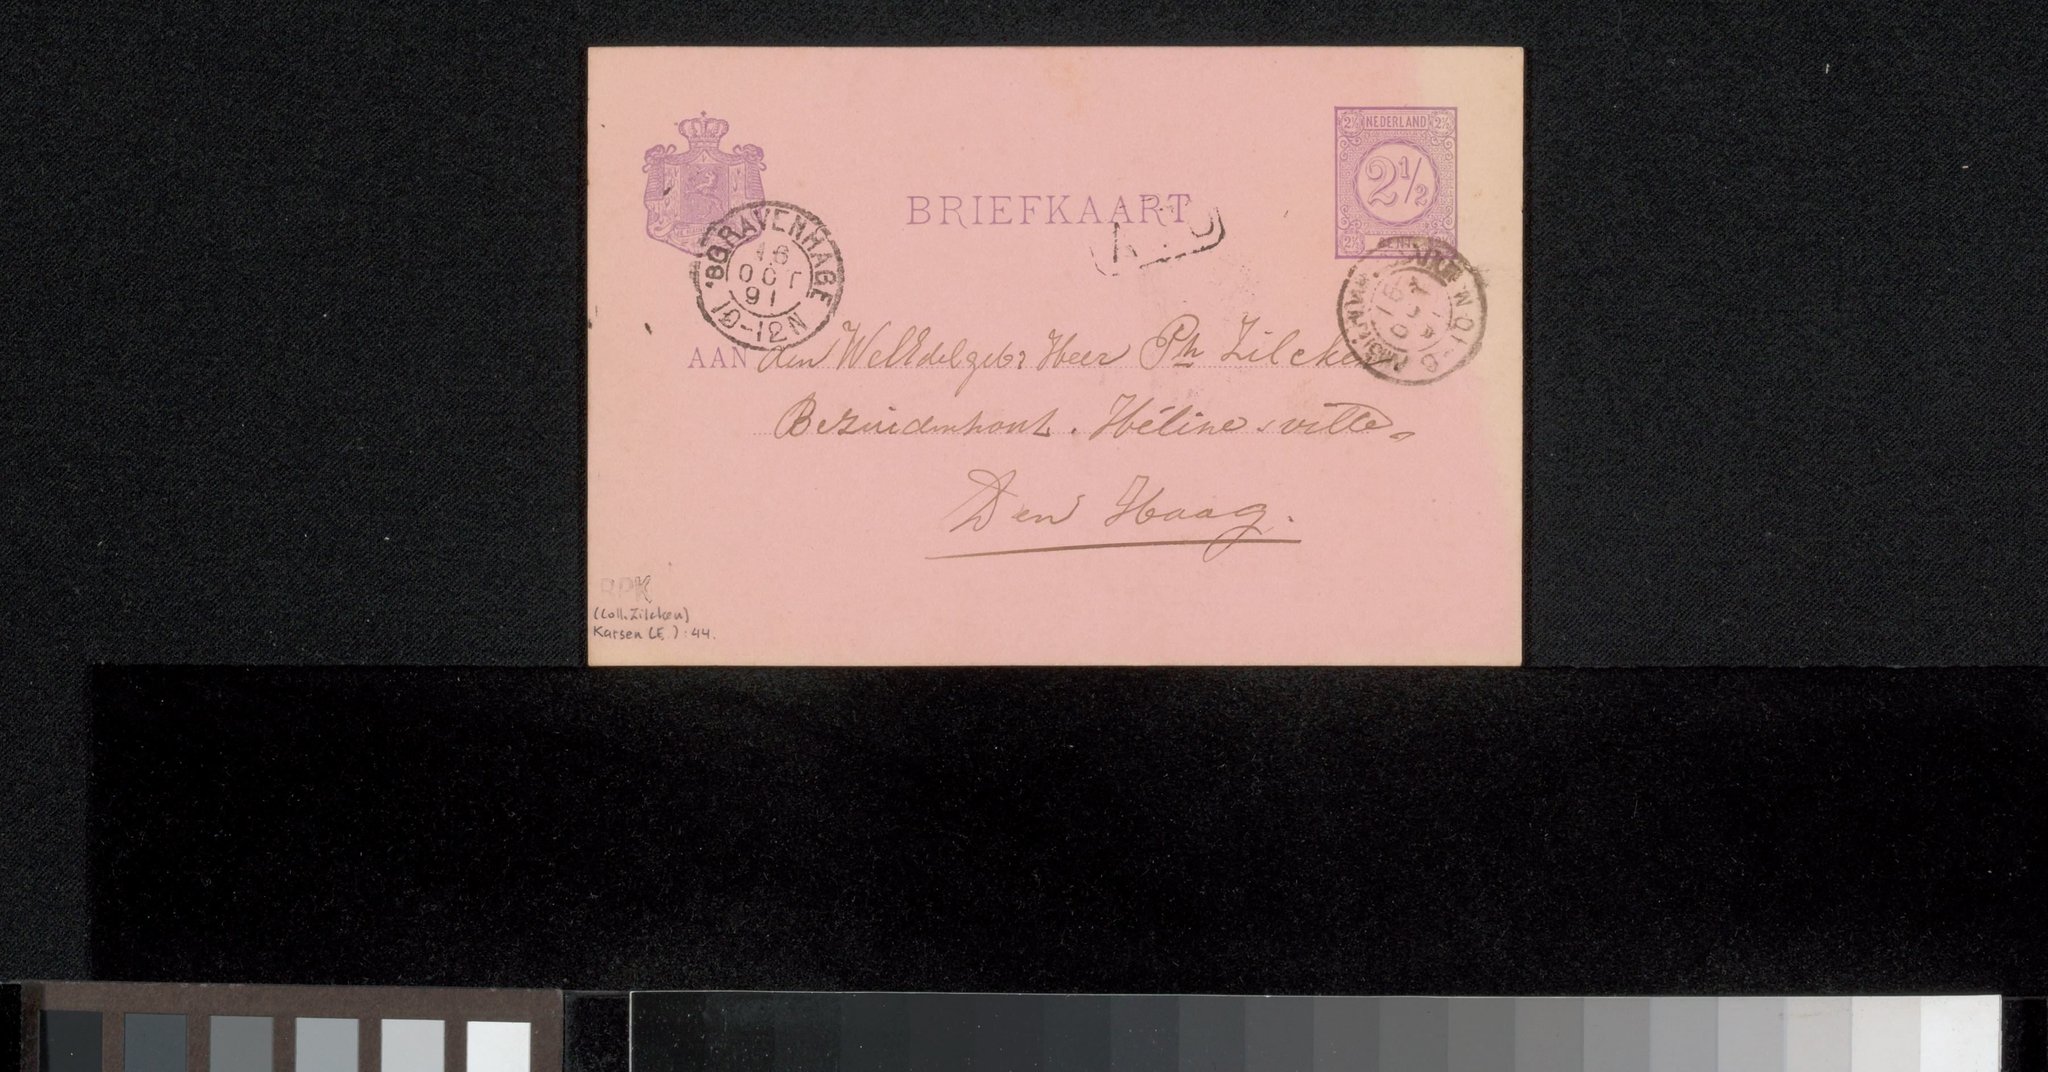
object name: postcard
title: Briefkaart aan Philip Zilcken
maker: eduard karsen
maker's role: draughtsman, painter, print maker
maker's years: 1860-1941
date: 1891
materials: cardboard, ink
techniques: pen, writing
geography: amsterdam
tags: the hague, amsterdam, print maker, draughtsman, marius bauer, paris, henri charles guérard, howard mansfield, philip zilcken, the graphic arts, money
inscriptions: collector's mark: ‘RPK’